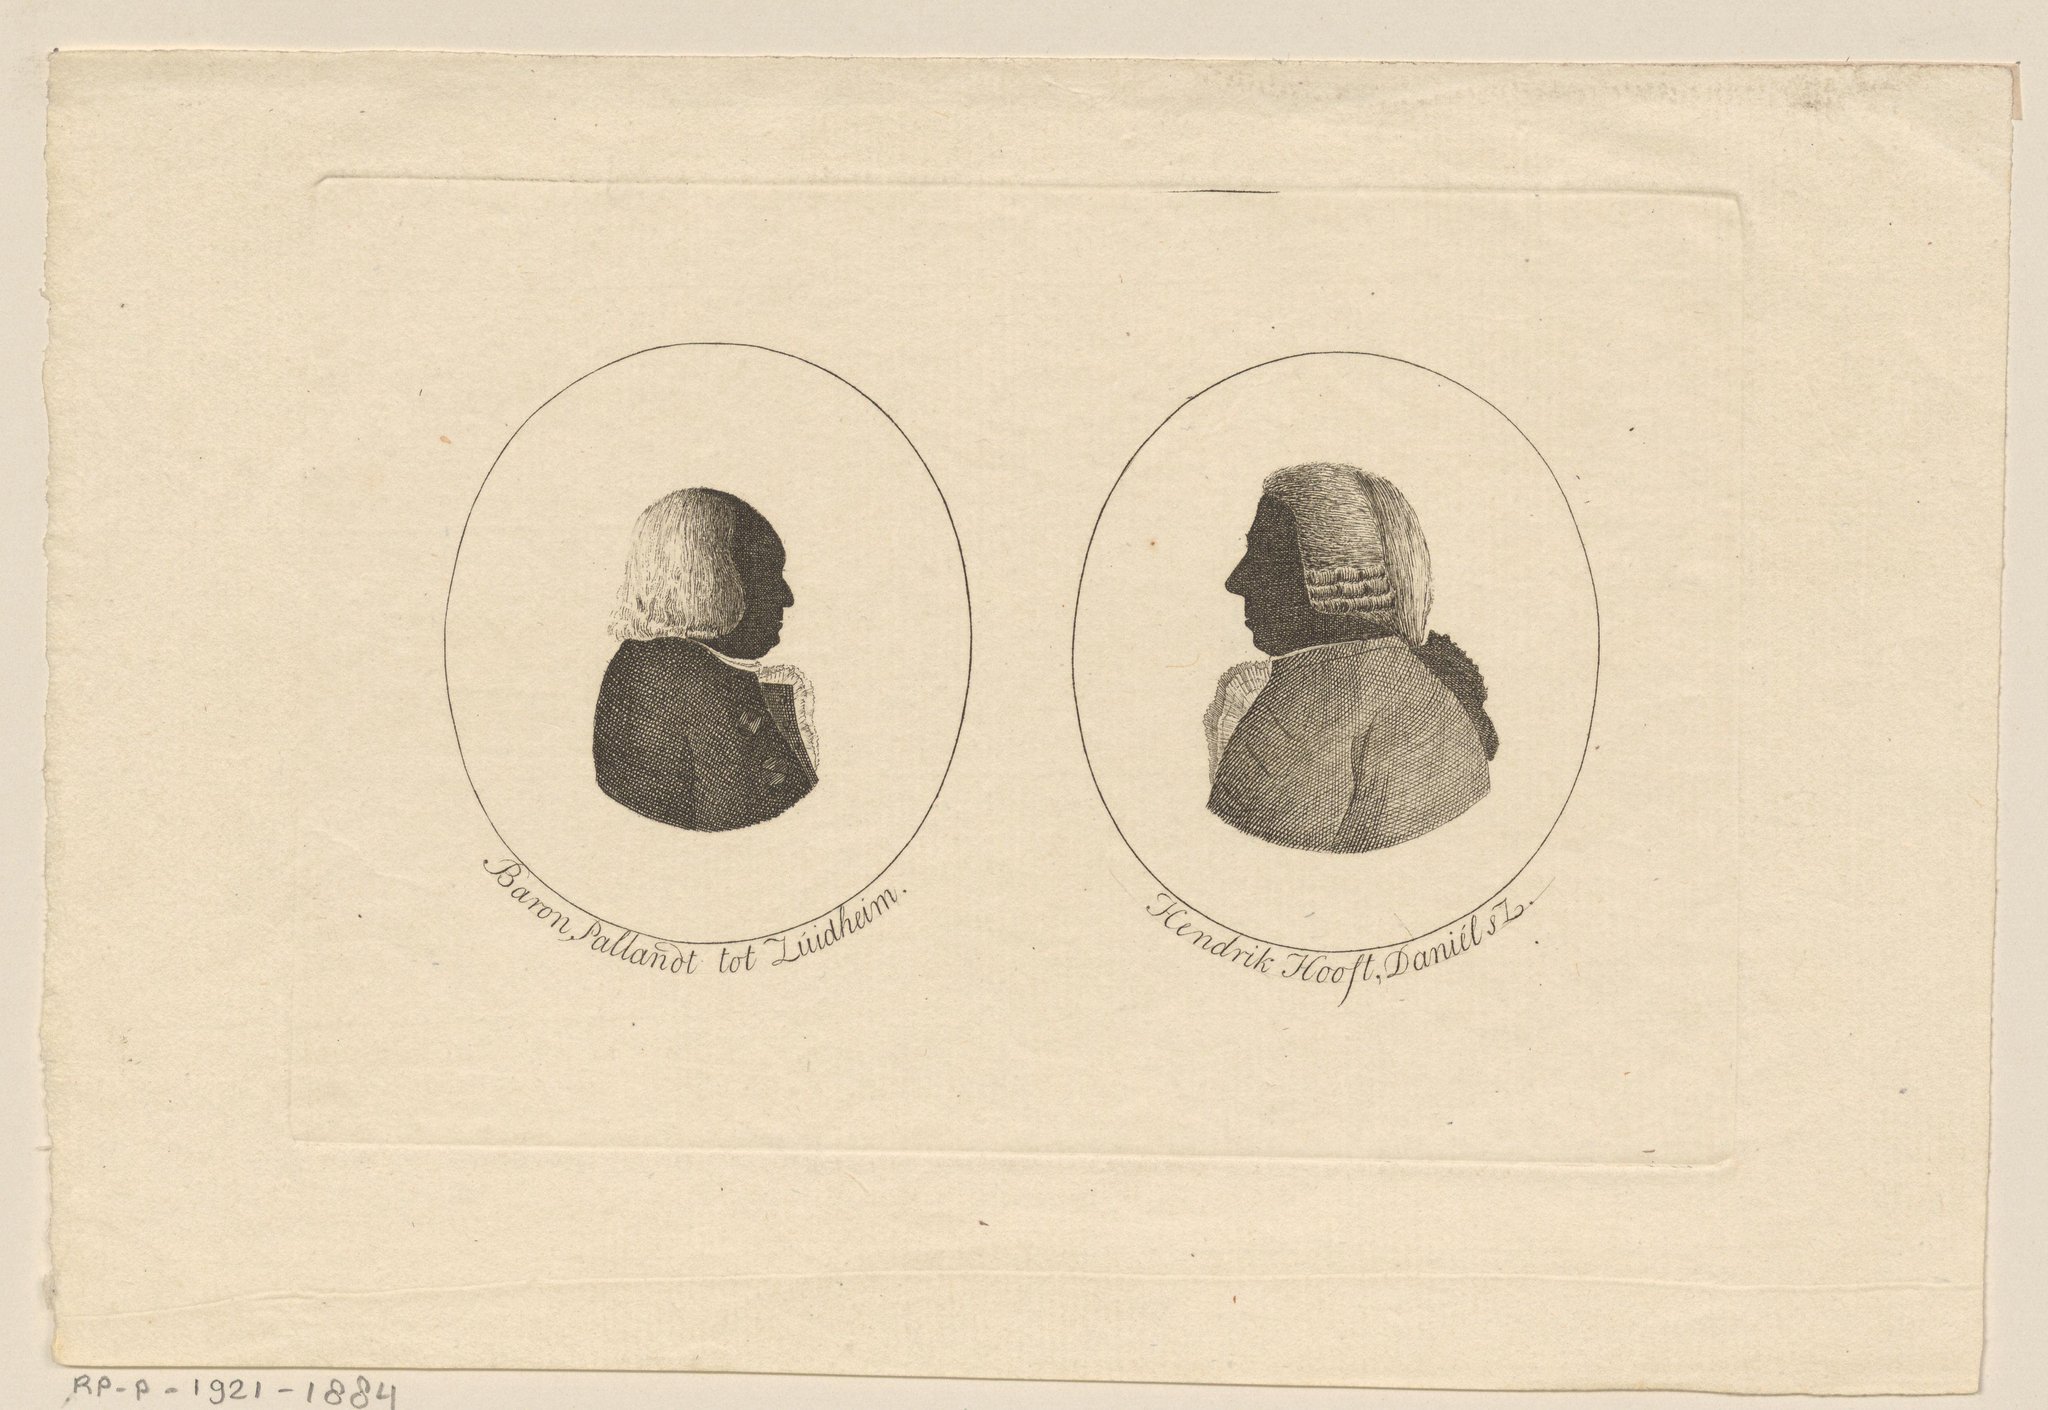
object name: print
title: Silhouetportretten van Adolph Werner van Pallandt tot Zuthem en Hendrik Danielsz. Hooft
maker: Anonymous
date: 1750-1799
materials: paper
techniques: engraving, etching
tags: amsterdam, mayor, hendrik danielsz. hooft, mayor, burgomaster, historical persons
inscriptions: collector's mark: Lugt 2233